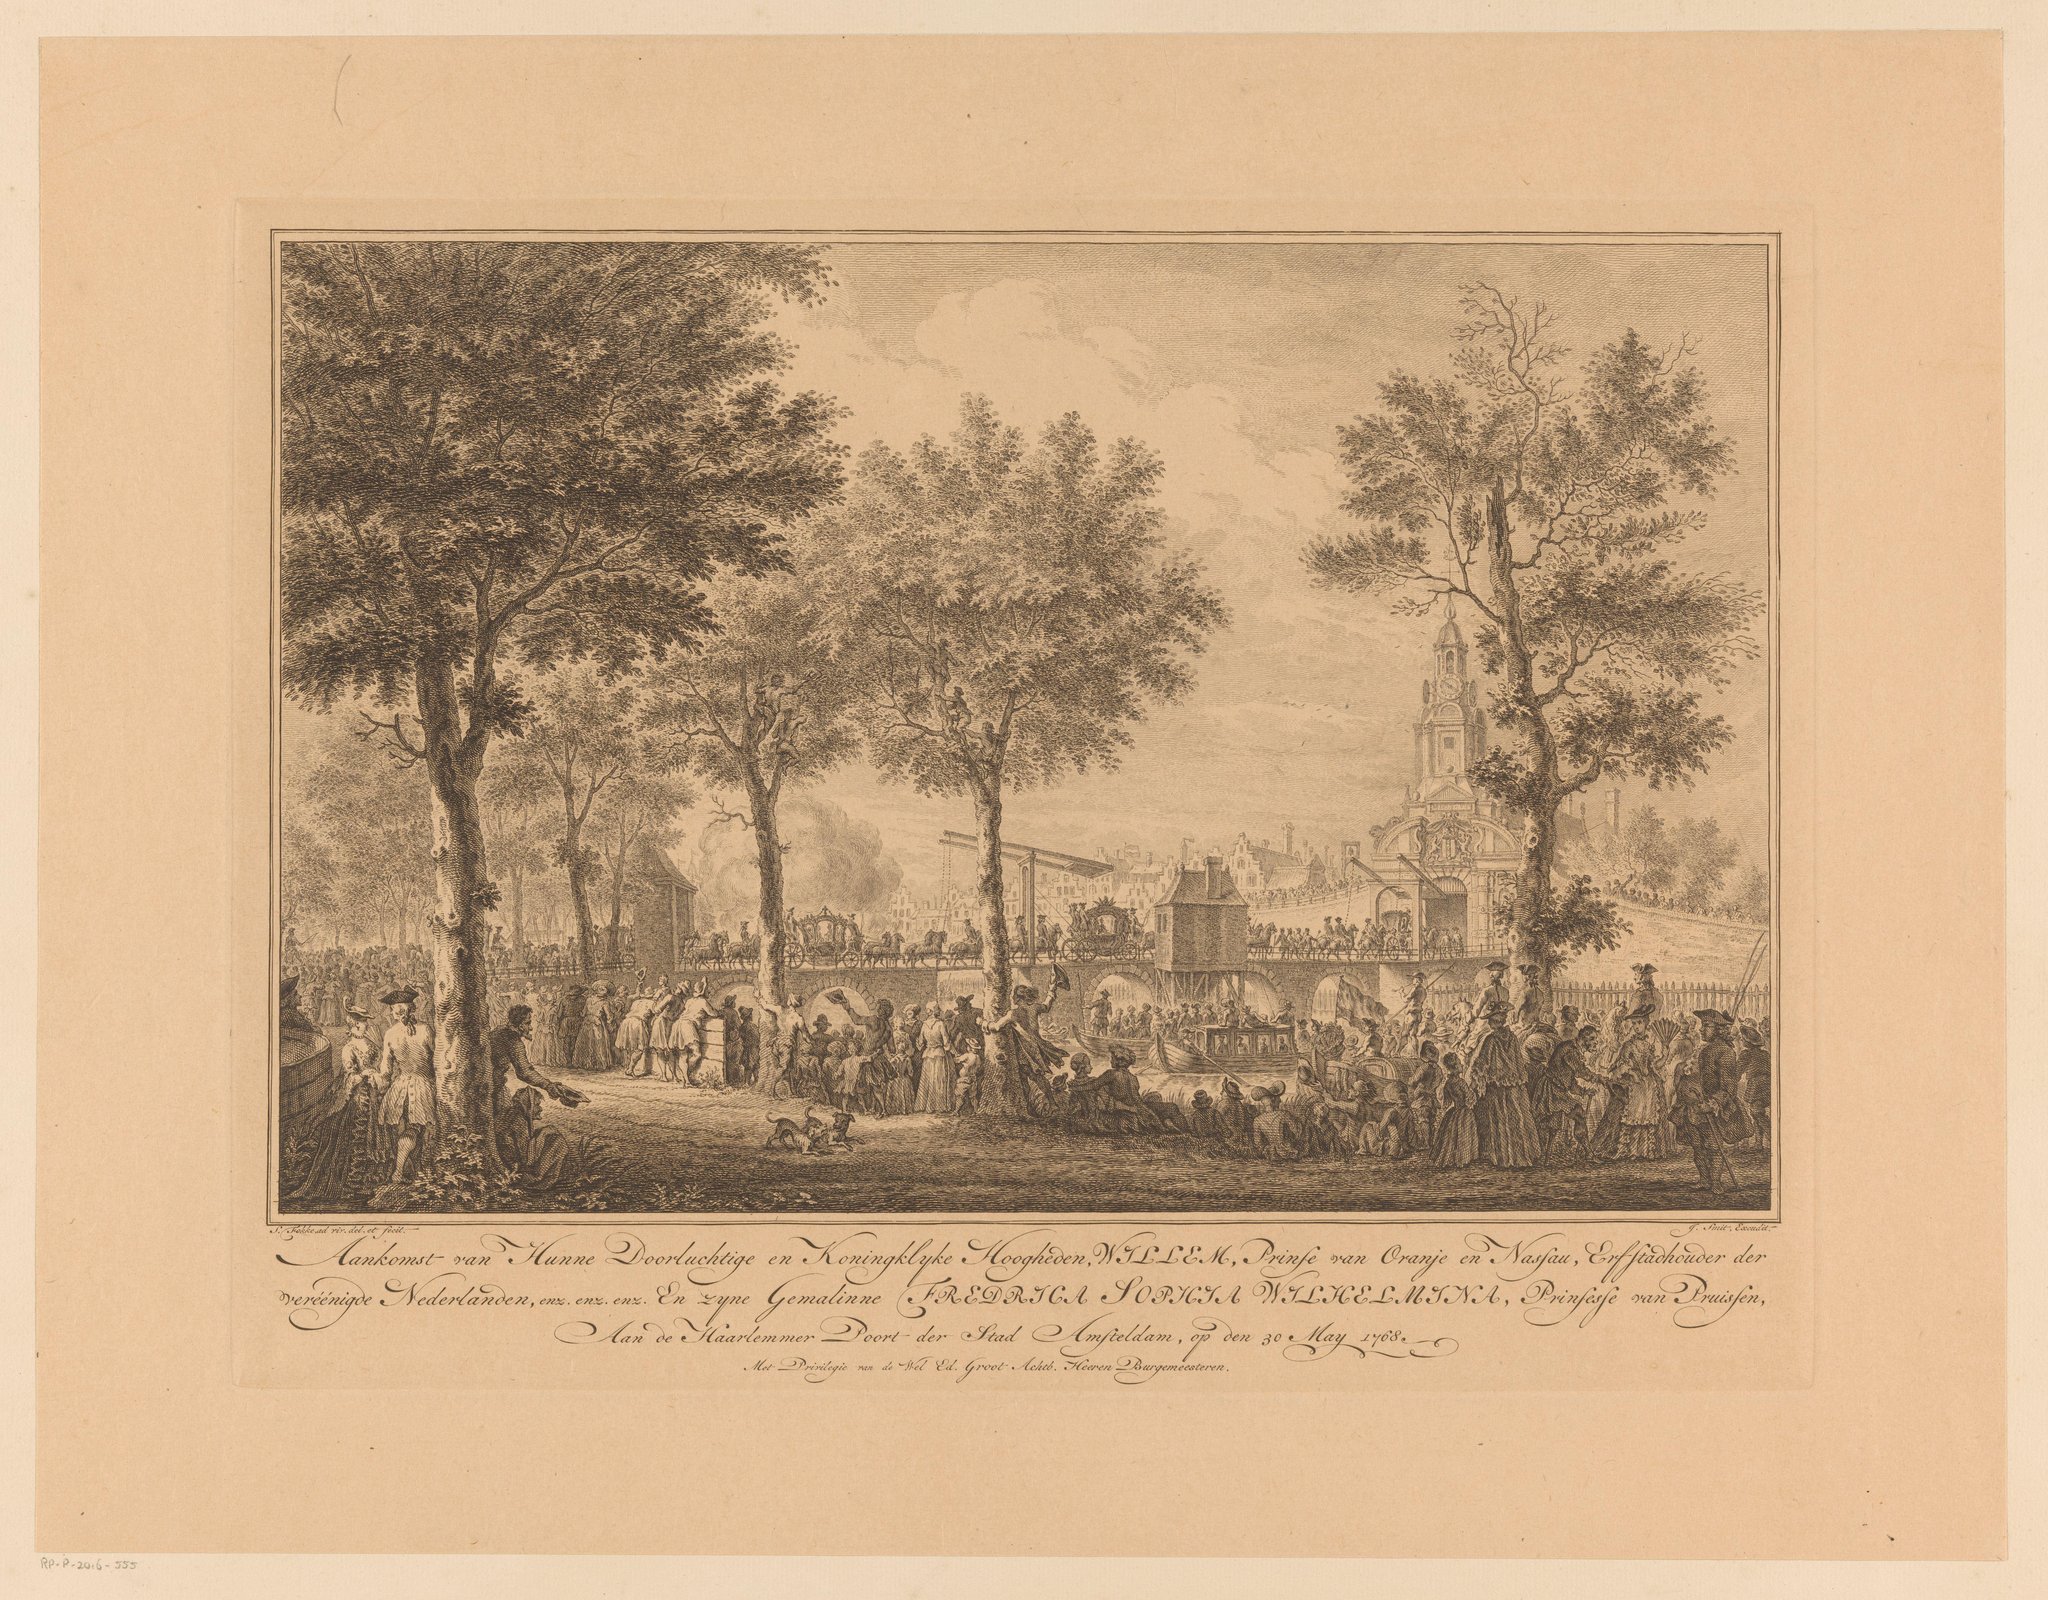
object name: print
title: Aankomst van hunne doorluchtige en koninklyke hoogheden, Willem, Prinse van Oranje en Nassau (...) En zyne gemalinne Fredrica Sophia Wilhelmina, Pinsesje van Pruissen, Aen de Haarlemmer Poort der stad Amsterdam, op den 30 May 1768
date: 1772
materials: paper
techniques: engraving, etching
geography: amsterdam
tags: william v (prince of orange), berlin, painter, draughtsman, wilhelmina of prussia (princess of orange), triumphal entry and public reception, pageant, 'entrée solennelle', 'joyeuse entrée'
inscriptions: collector's mark: Lugt 2228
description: Aankomst van de stoet met stadhouder Willem V en prinses Wilhelmina van Pruisen bij de Haarlemmerpoort te Amsterdam, op 30 mei 1768. Met grote groepen toeschouwers op de kades en op het water.